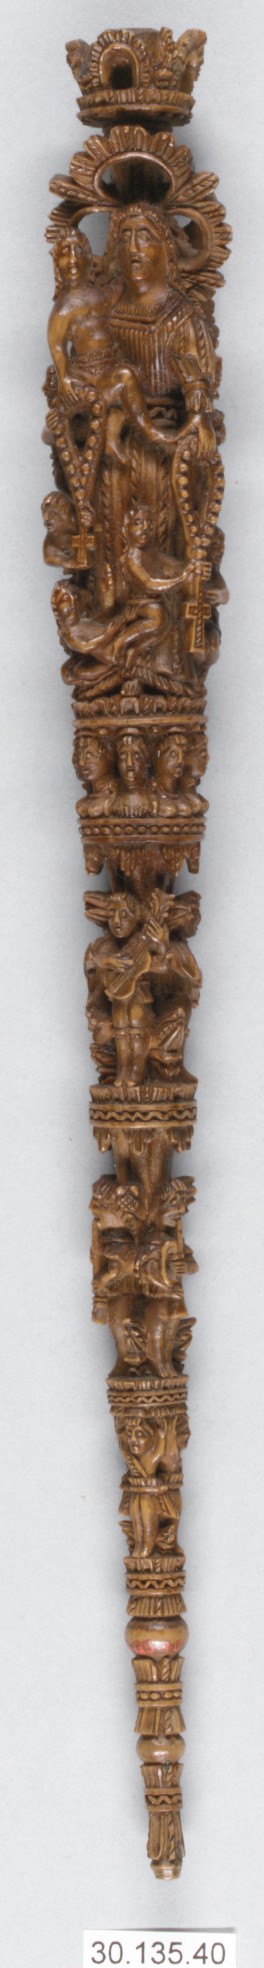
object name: needle sheath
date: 1601-1700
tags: musical instruments,madonna and child